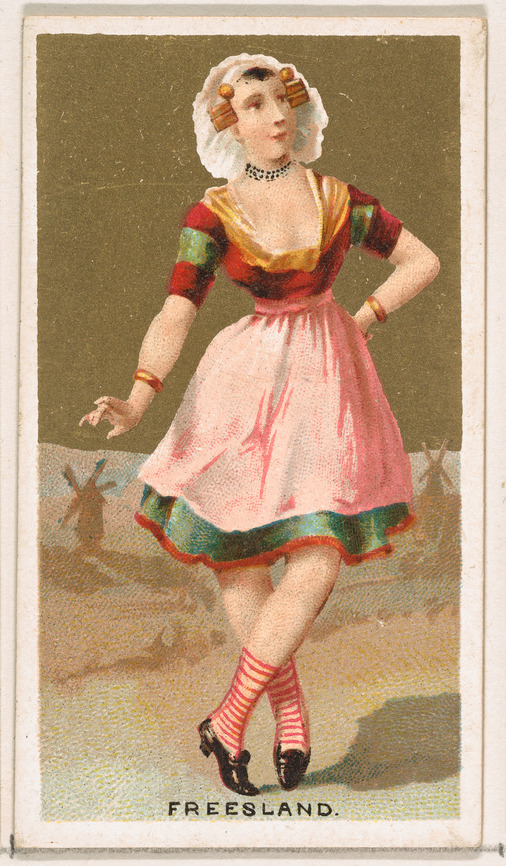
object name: print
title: Freesland, from the Dancing Girls of the World series (N185) issued by Wm. S. Kimball & Co.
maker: william s. kimball & company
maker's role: publisher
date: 1889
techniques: color lithograph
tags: women,dancing,dancers